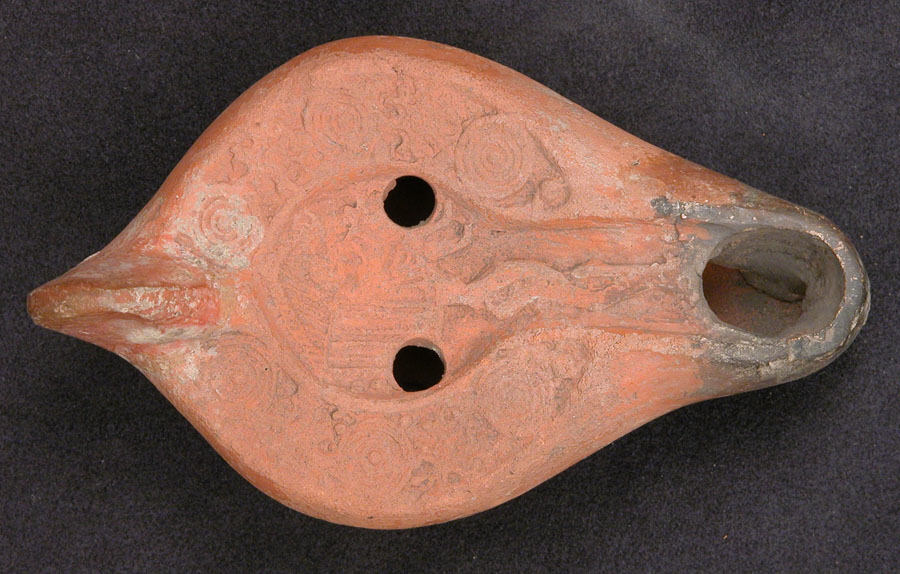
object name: lamp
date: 401-600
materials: earthenware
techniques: molding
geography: egypt